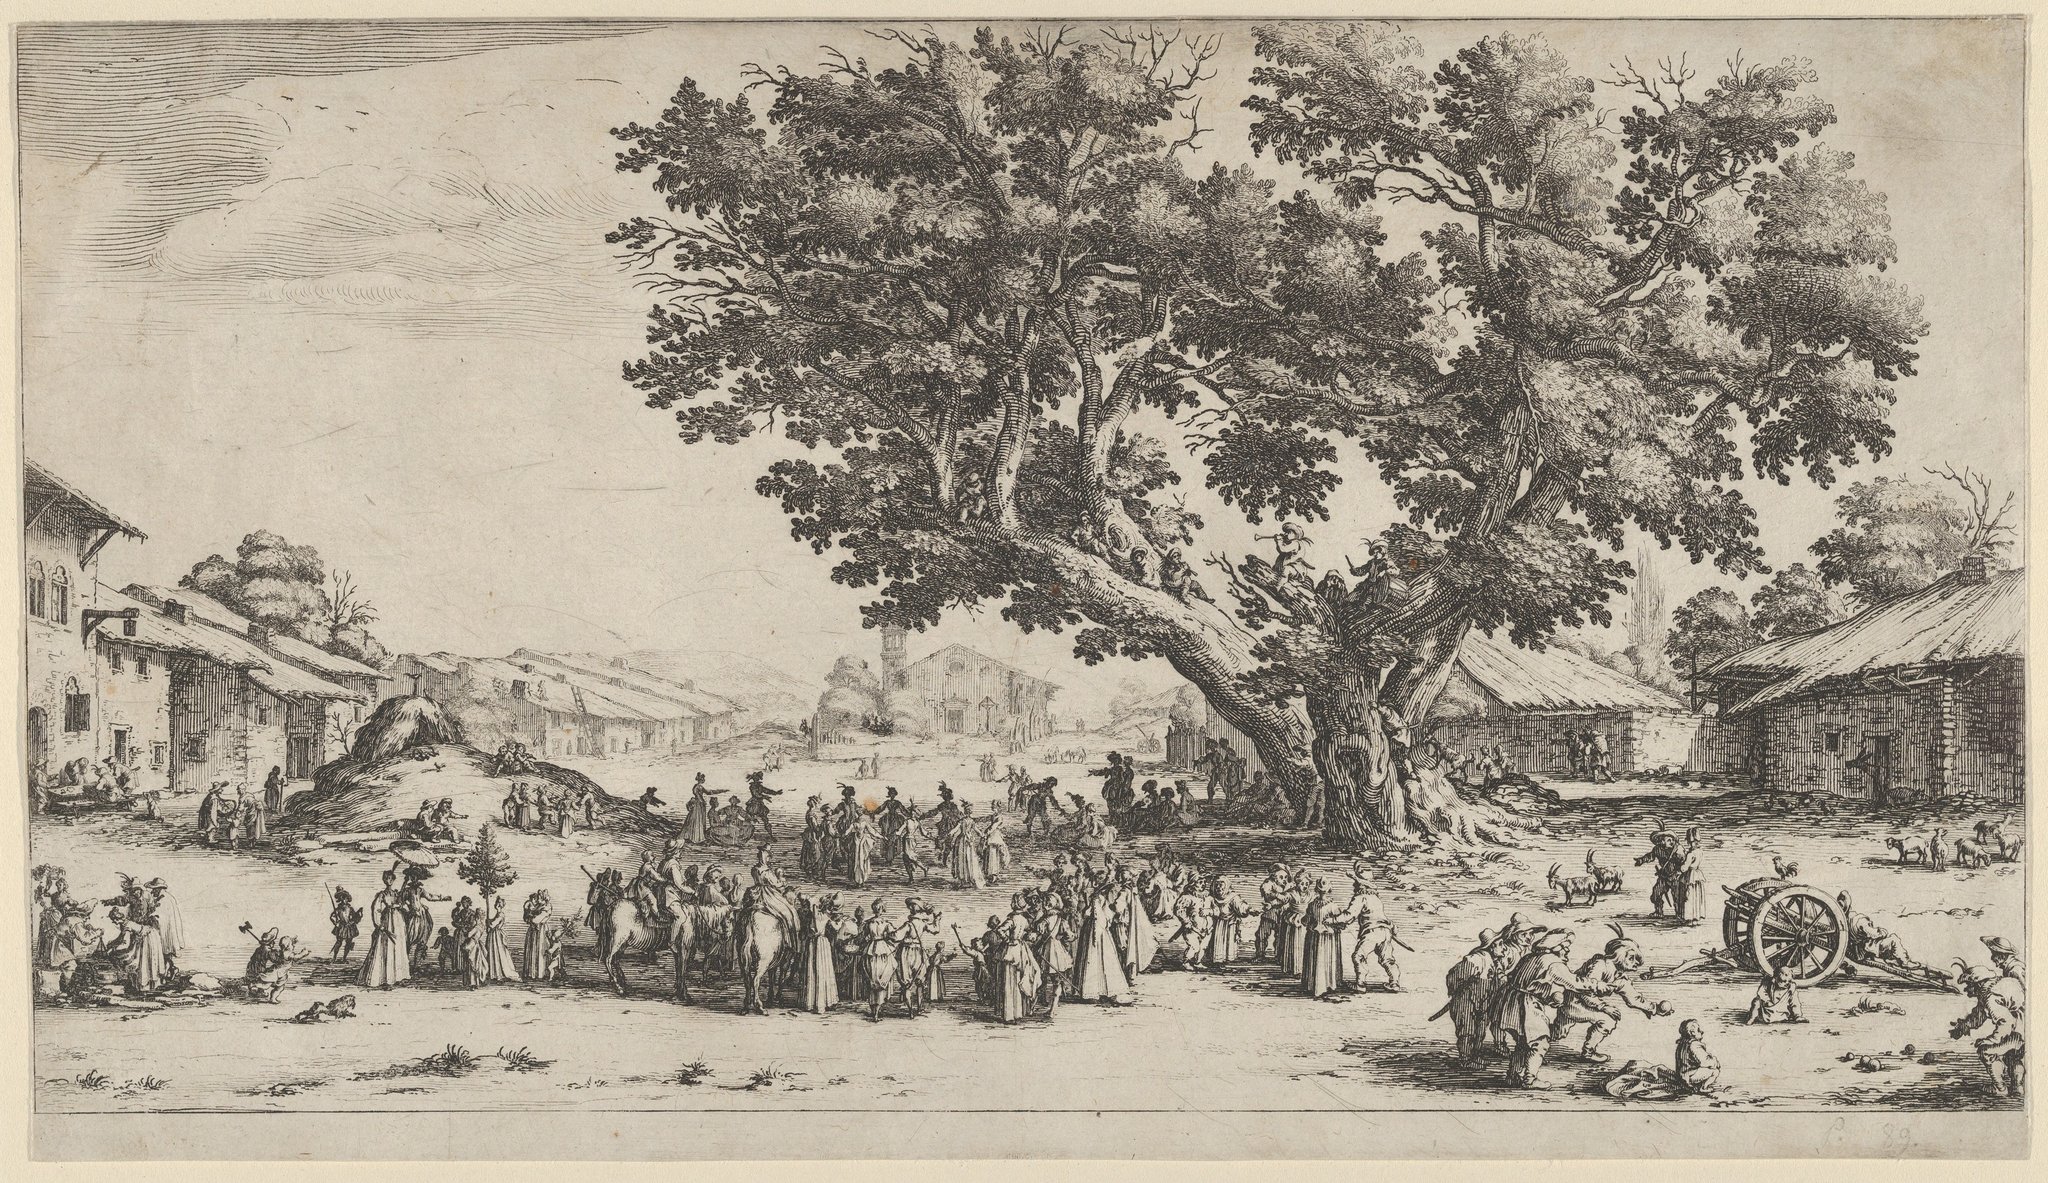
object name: print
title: May Day Celebrations at Xeuilley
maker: jacques callot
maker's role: artist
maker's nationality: french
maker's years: 1592-1635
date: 1624-1625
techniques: etching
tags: men,women,dancing,trees